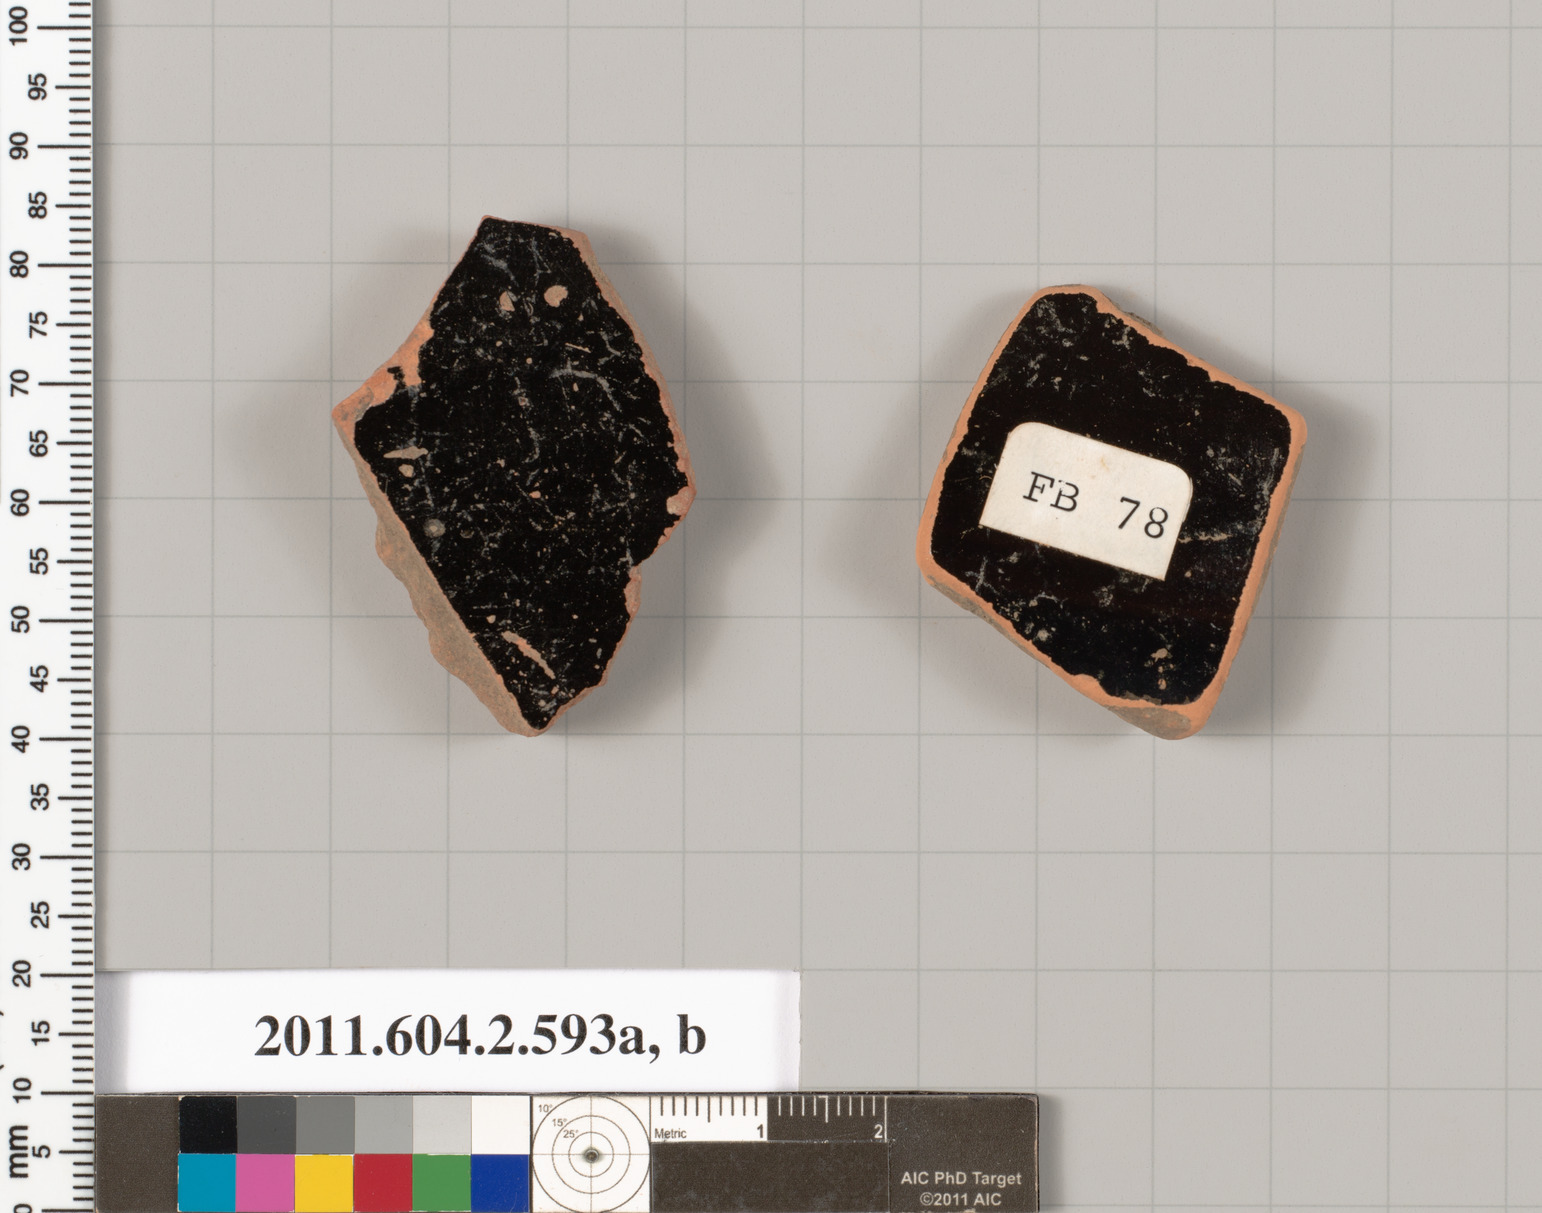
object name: column krater fragment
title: Terracotta fragments of column-kraters (bowls for mixing wine and water)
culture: greek, attic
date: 470-440 BCE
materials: terracotta